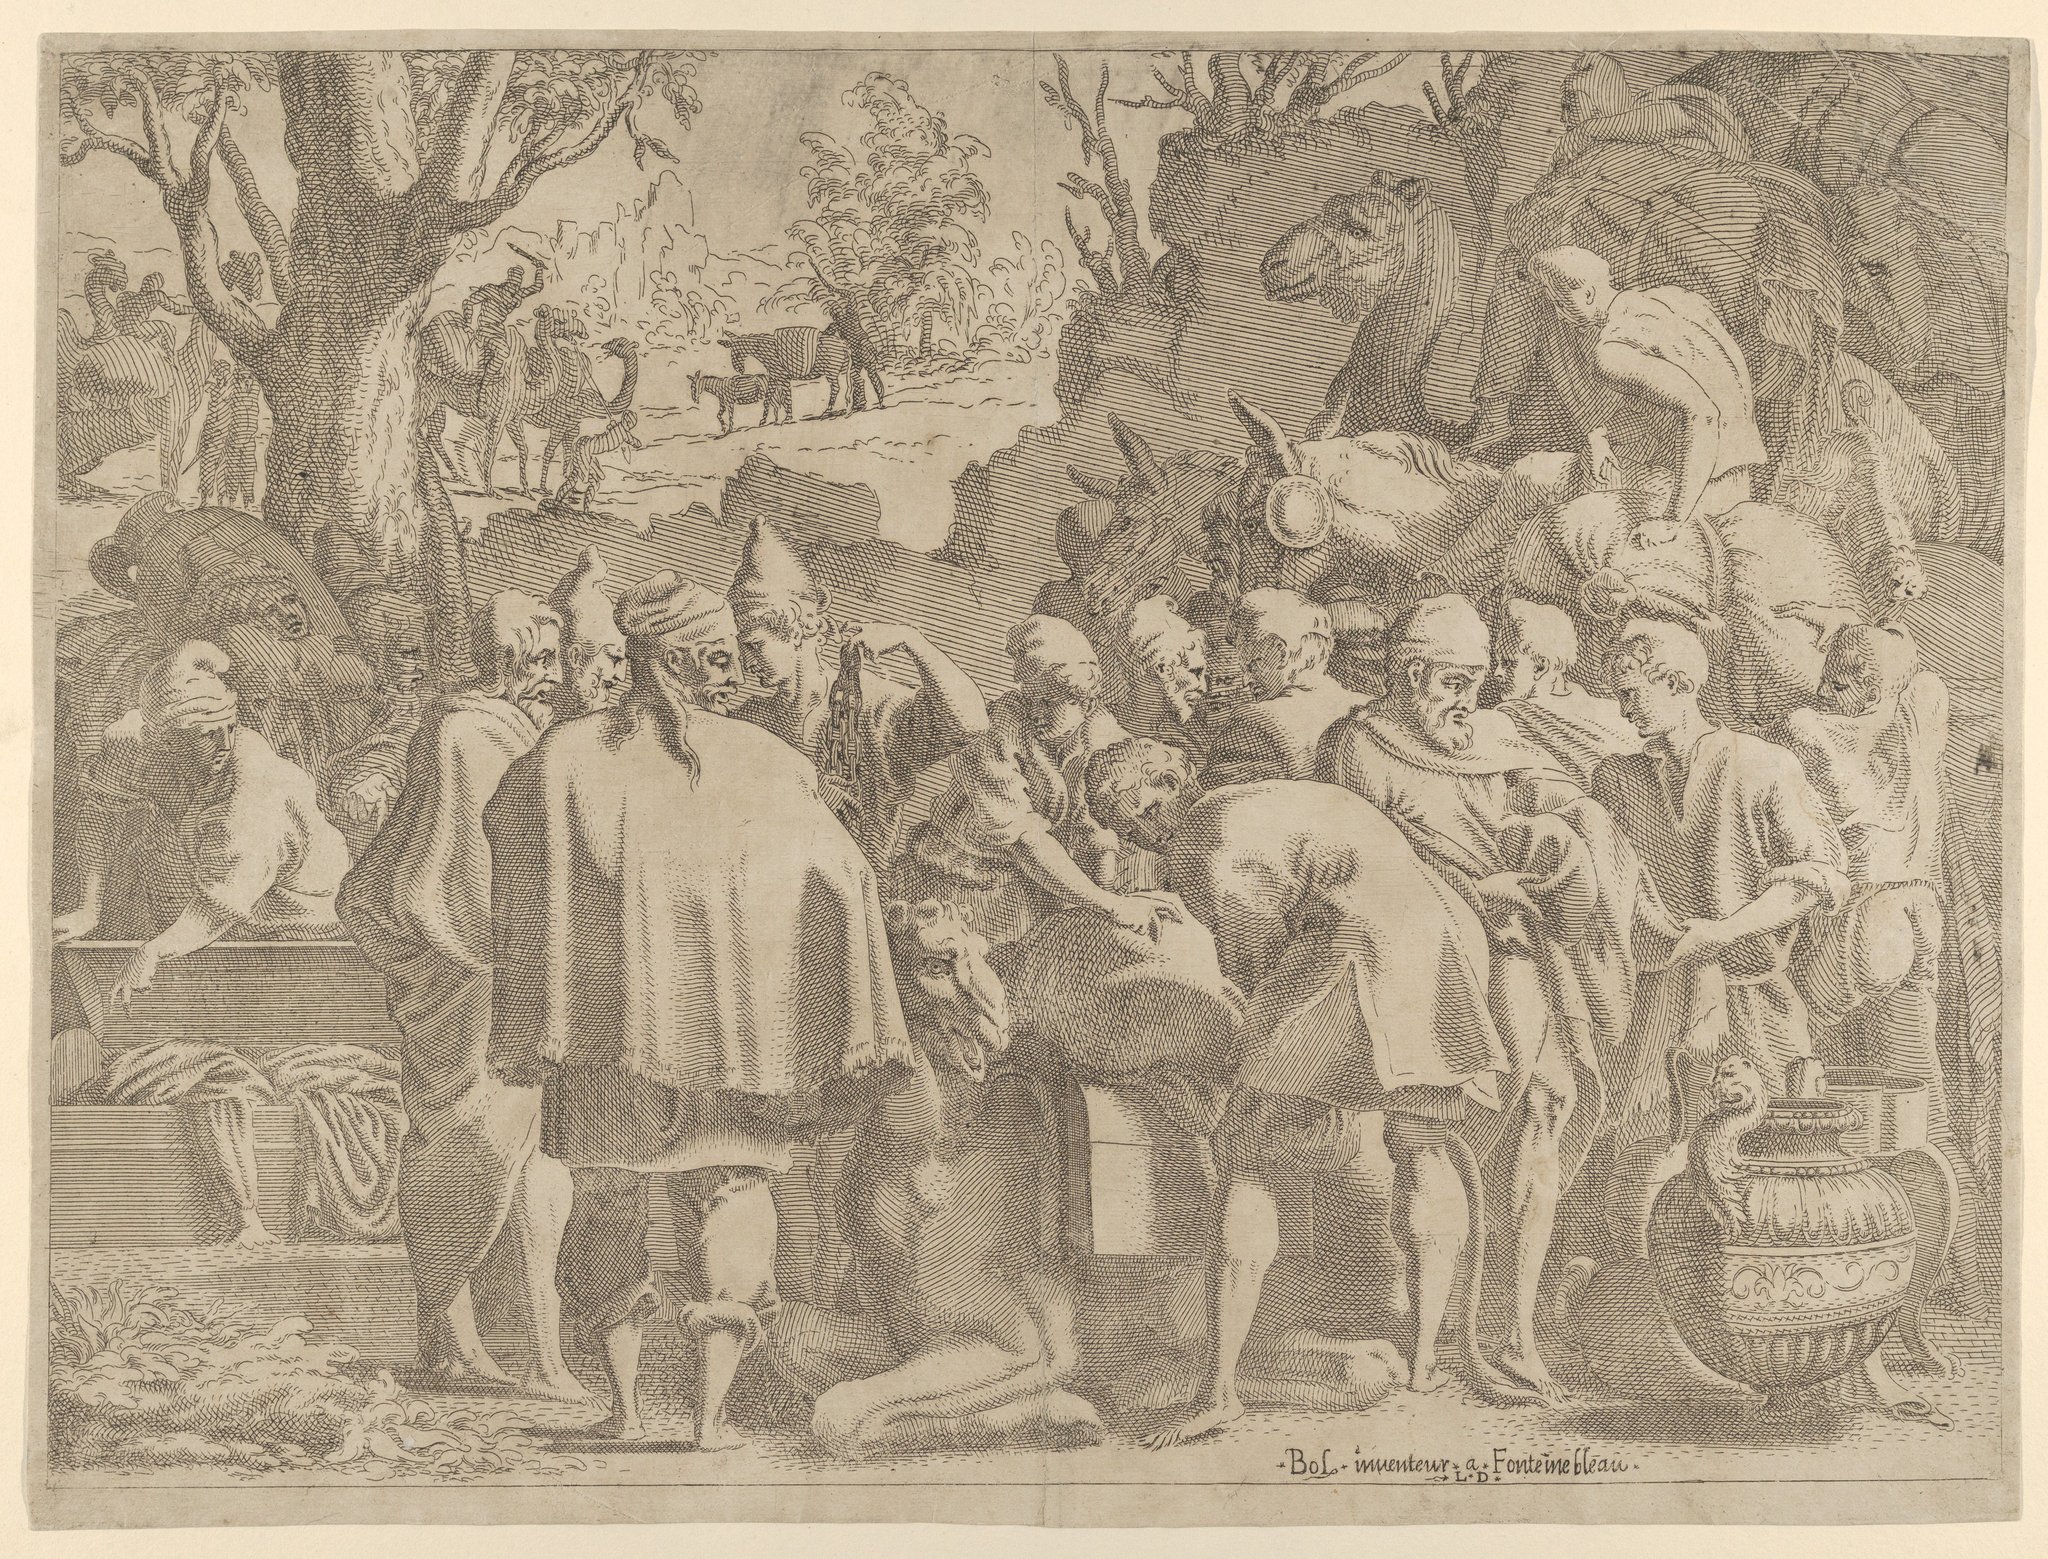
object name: print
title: Men Gathered Around a Camel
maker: léon davent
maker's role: artist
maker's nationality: french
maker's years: 1540-1556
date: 1534-1566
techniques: etching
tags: men,camels,horses